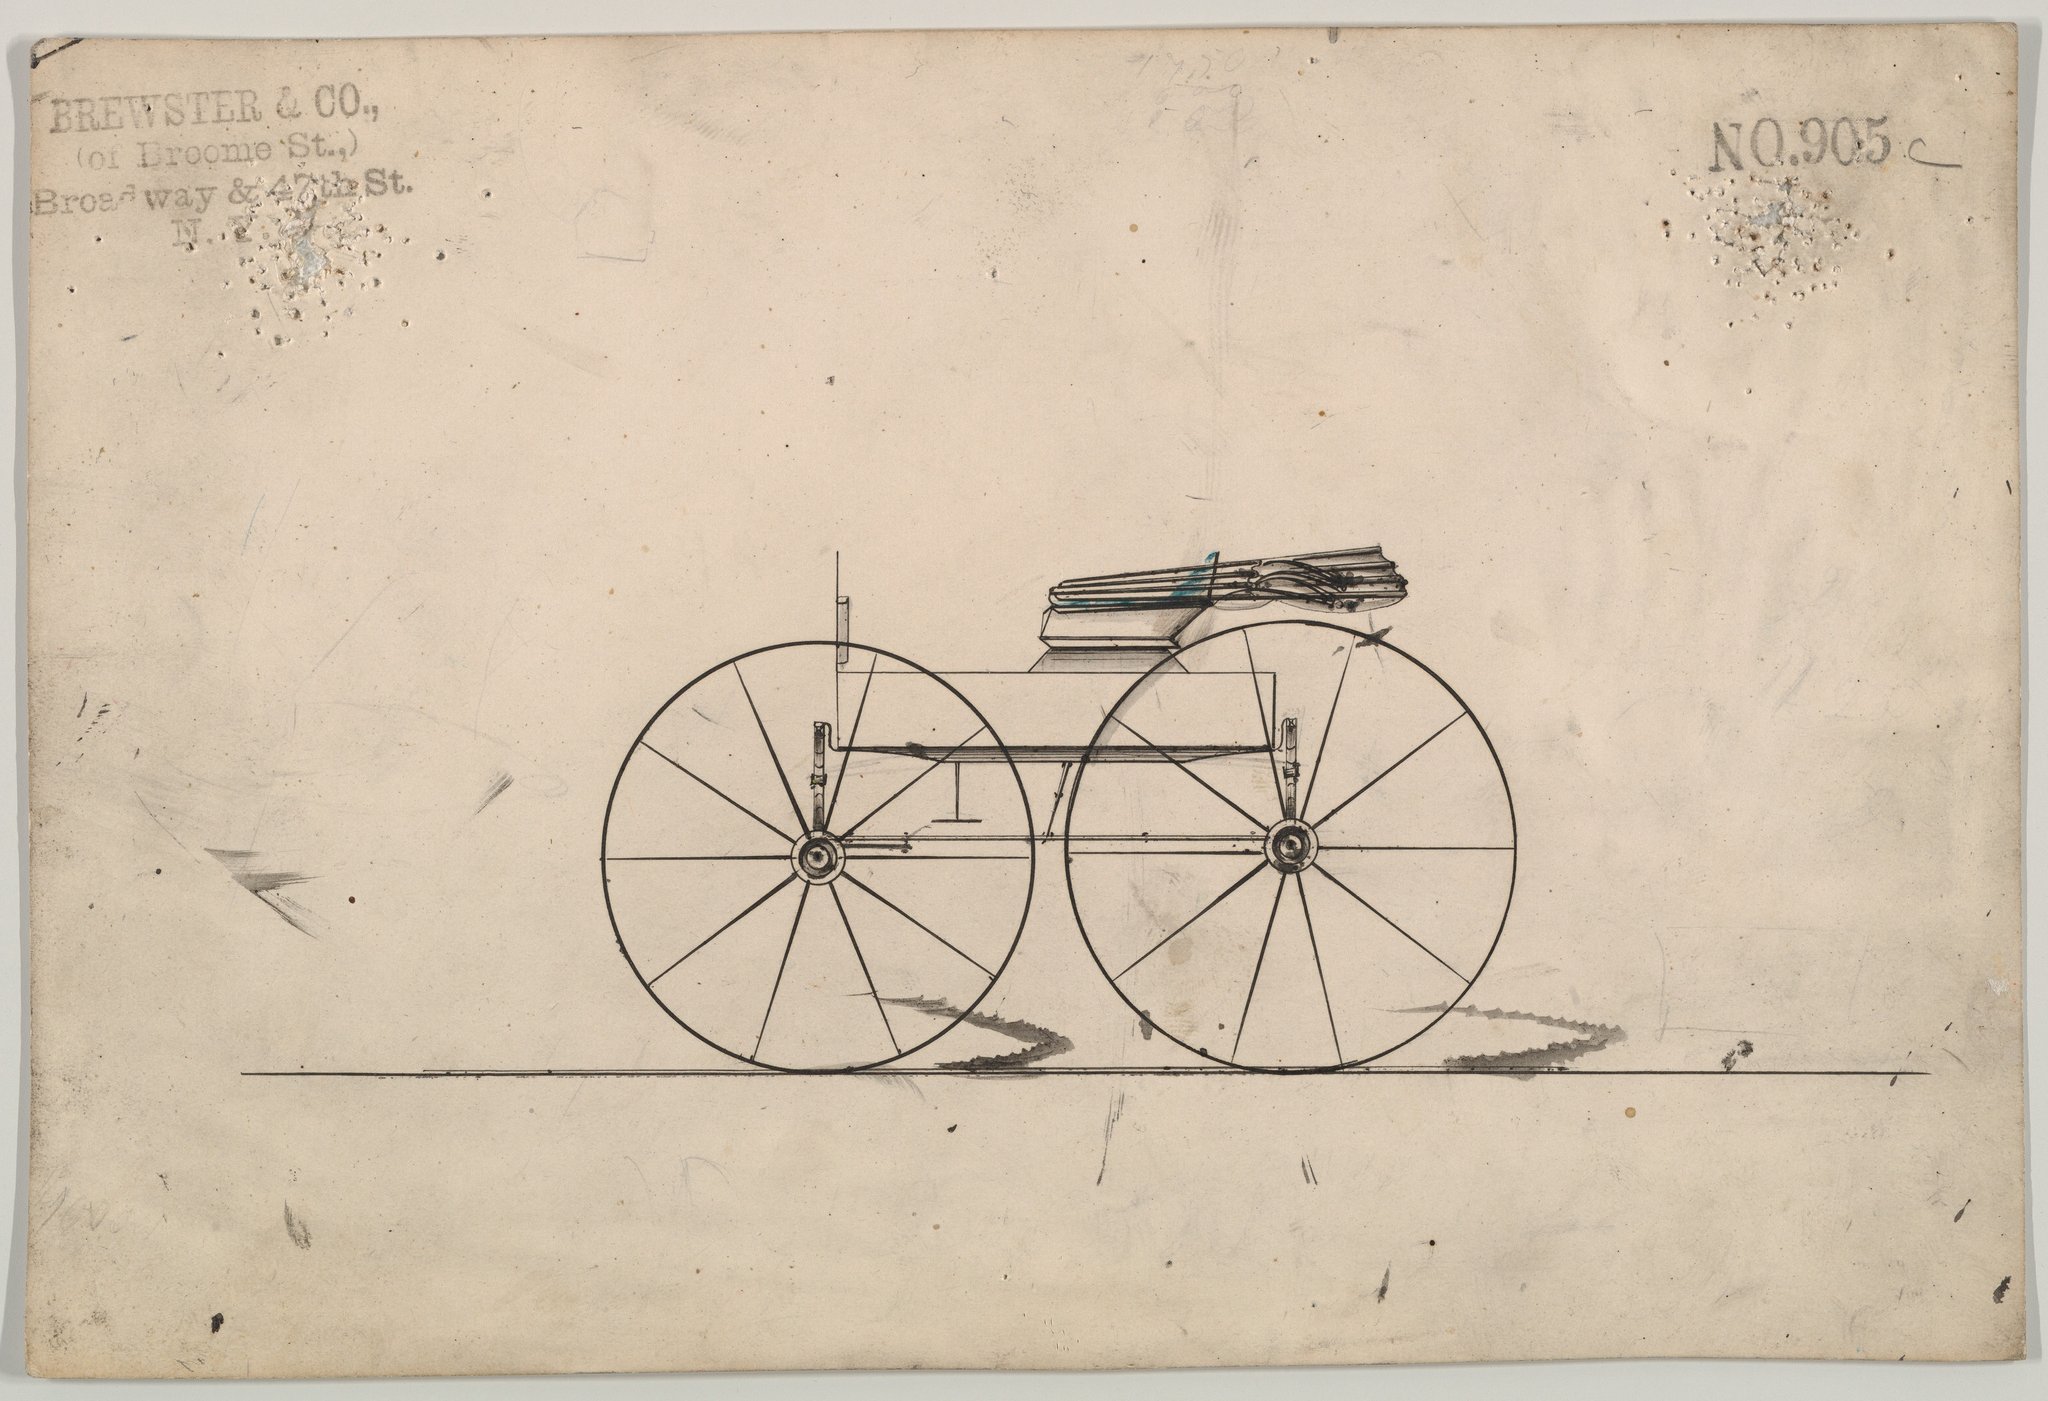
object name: drawing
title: Design for Wagon, no. 905c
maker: brewster & co.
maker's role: manufacturer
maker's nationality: american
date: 1870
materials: gouache, ink, watercolor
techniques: pen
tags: carriages